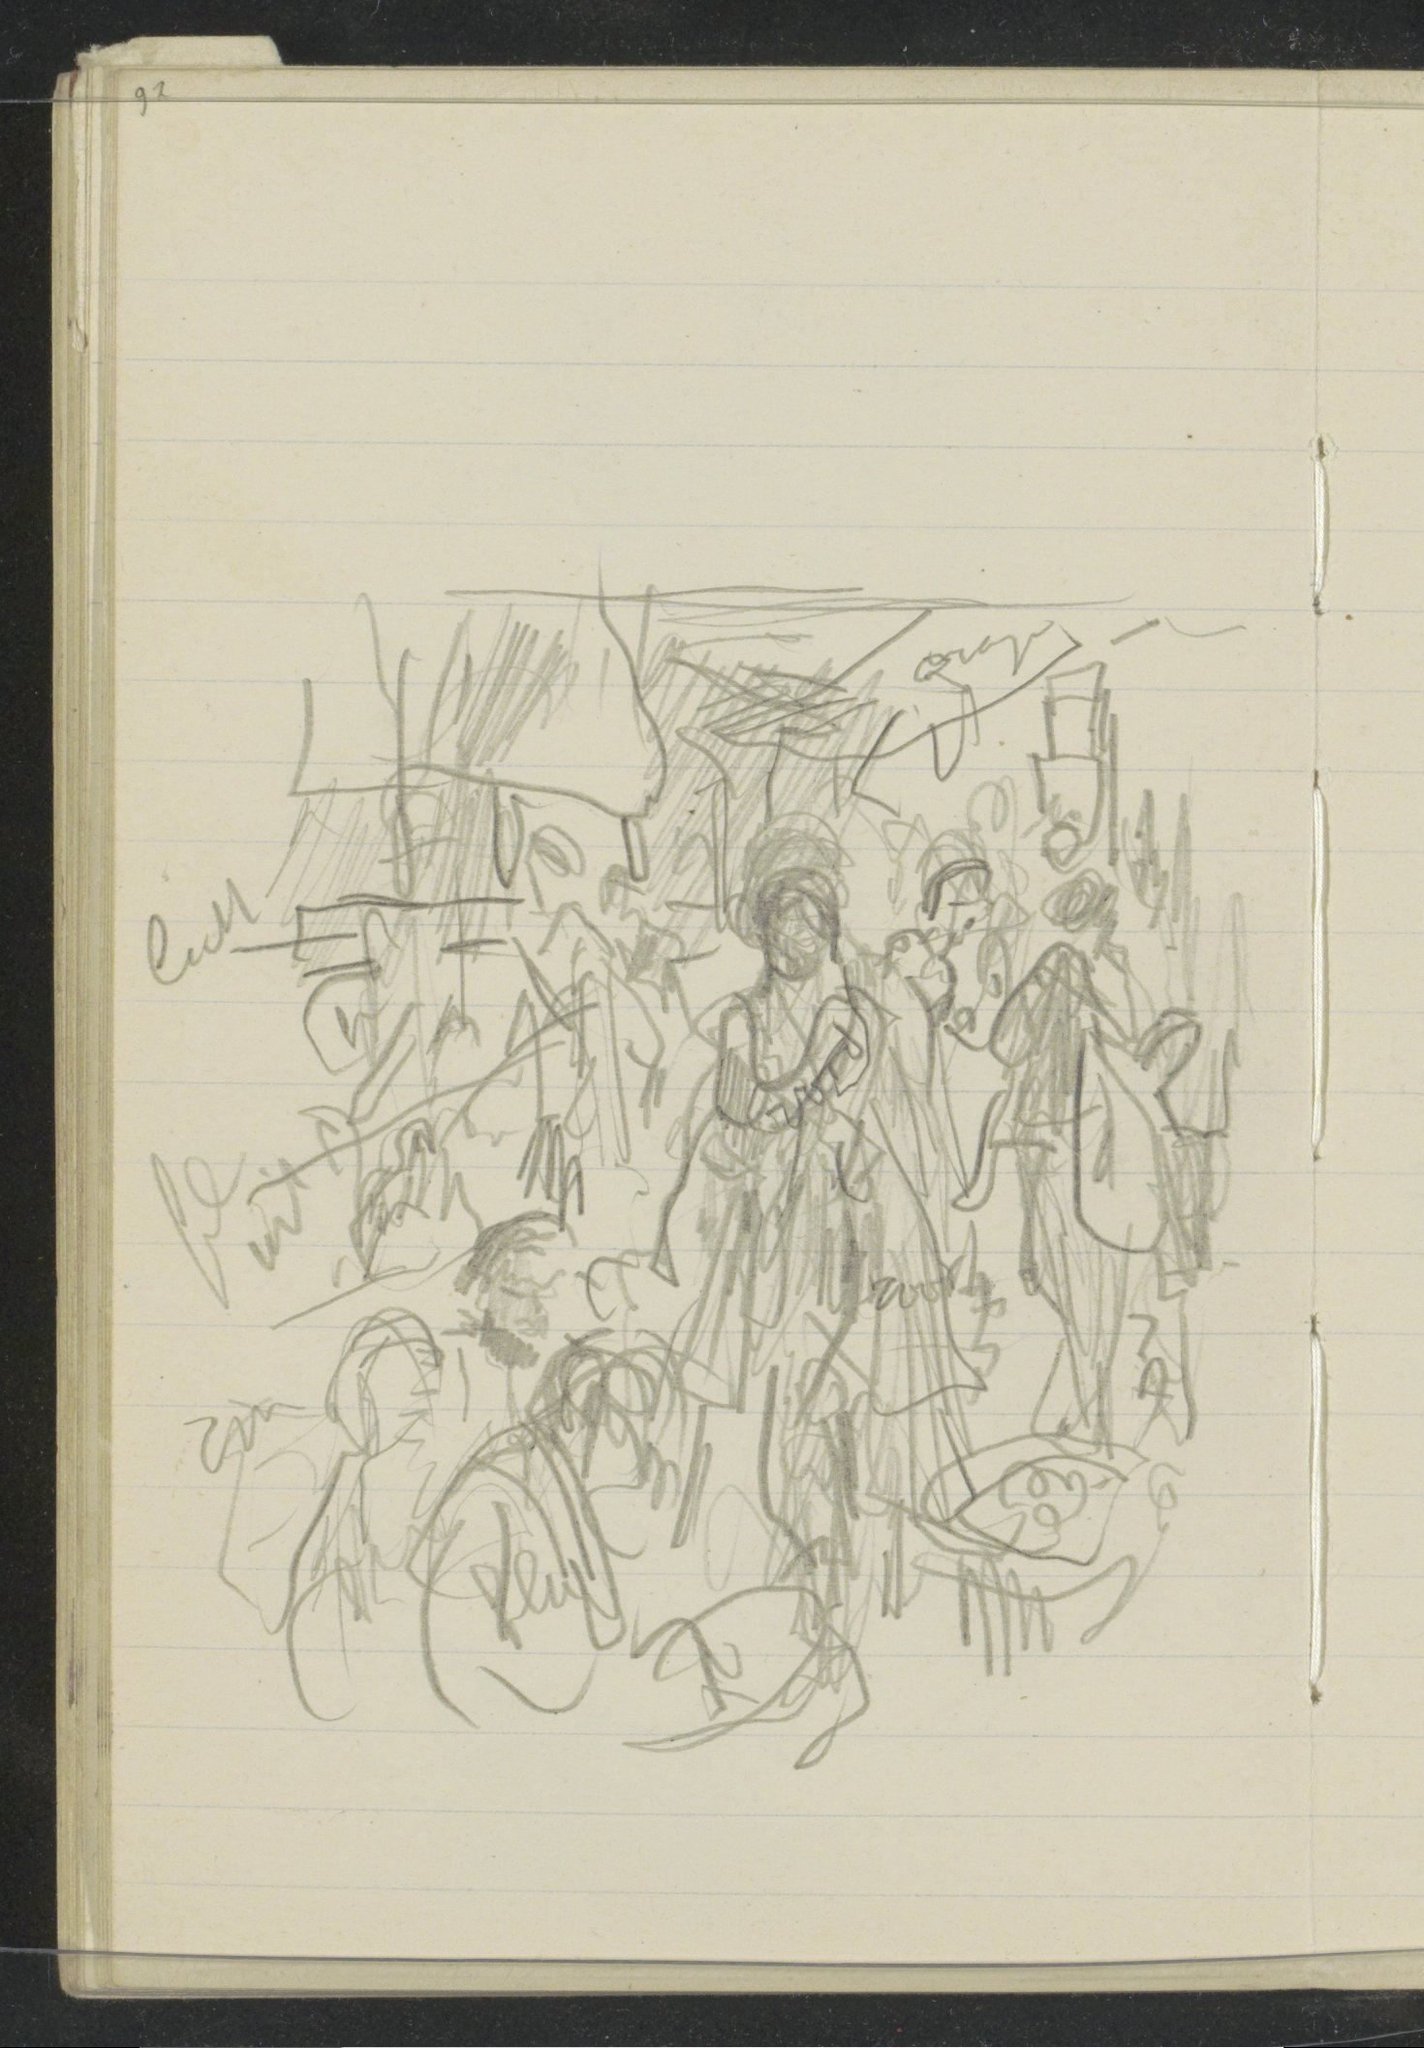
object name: sketchbook leaf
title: Straat met figuren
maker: marius bauer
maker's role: draughtsman, print maker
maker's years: 1867-1932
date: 1931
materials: pencil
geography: java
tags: asiatic races and peoples, street (+ city(-scape) with figures, staffage)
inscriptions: kleurnotitie, handgeschreven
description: Pagina 92 uit een schetsboek met 74 bladen.